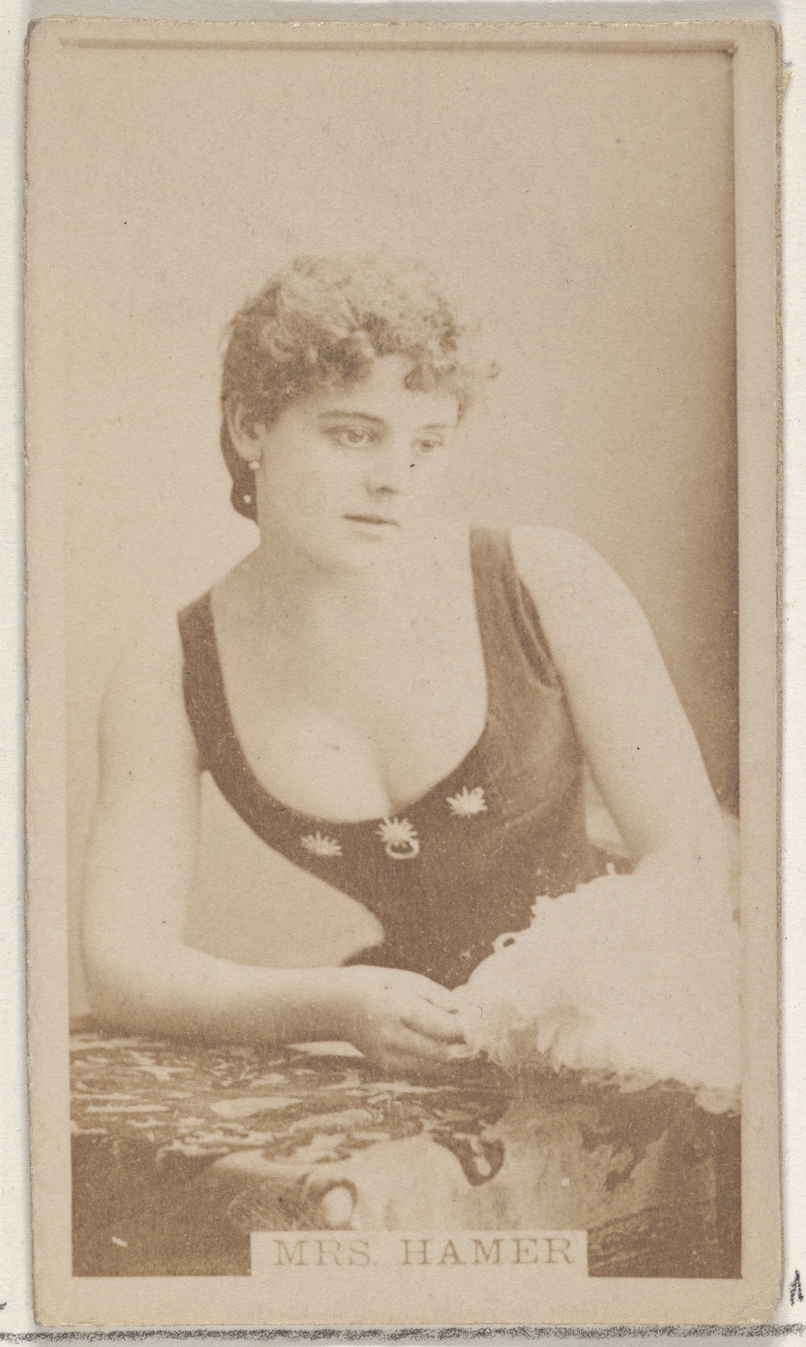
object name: photograph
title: Mrs. Hamer, from the Actors and Actresses series (N45, Type 8) for Virginia Brights Cigarettes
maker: allen & ginter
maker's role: publisher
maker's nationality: american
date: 1888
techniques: albumen silver print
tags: portraits,women,actresses